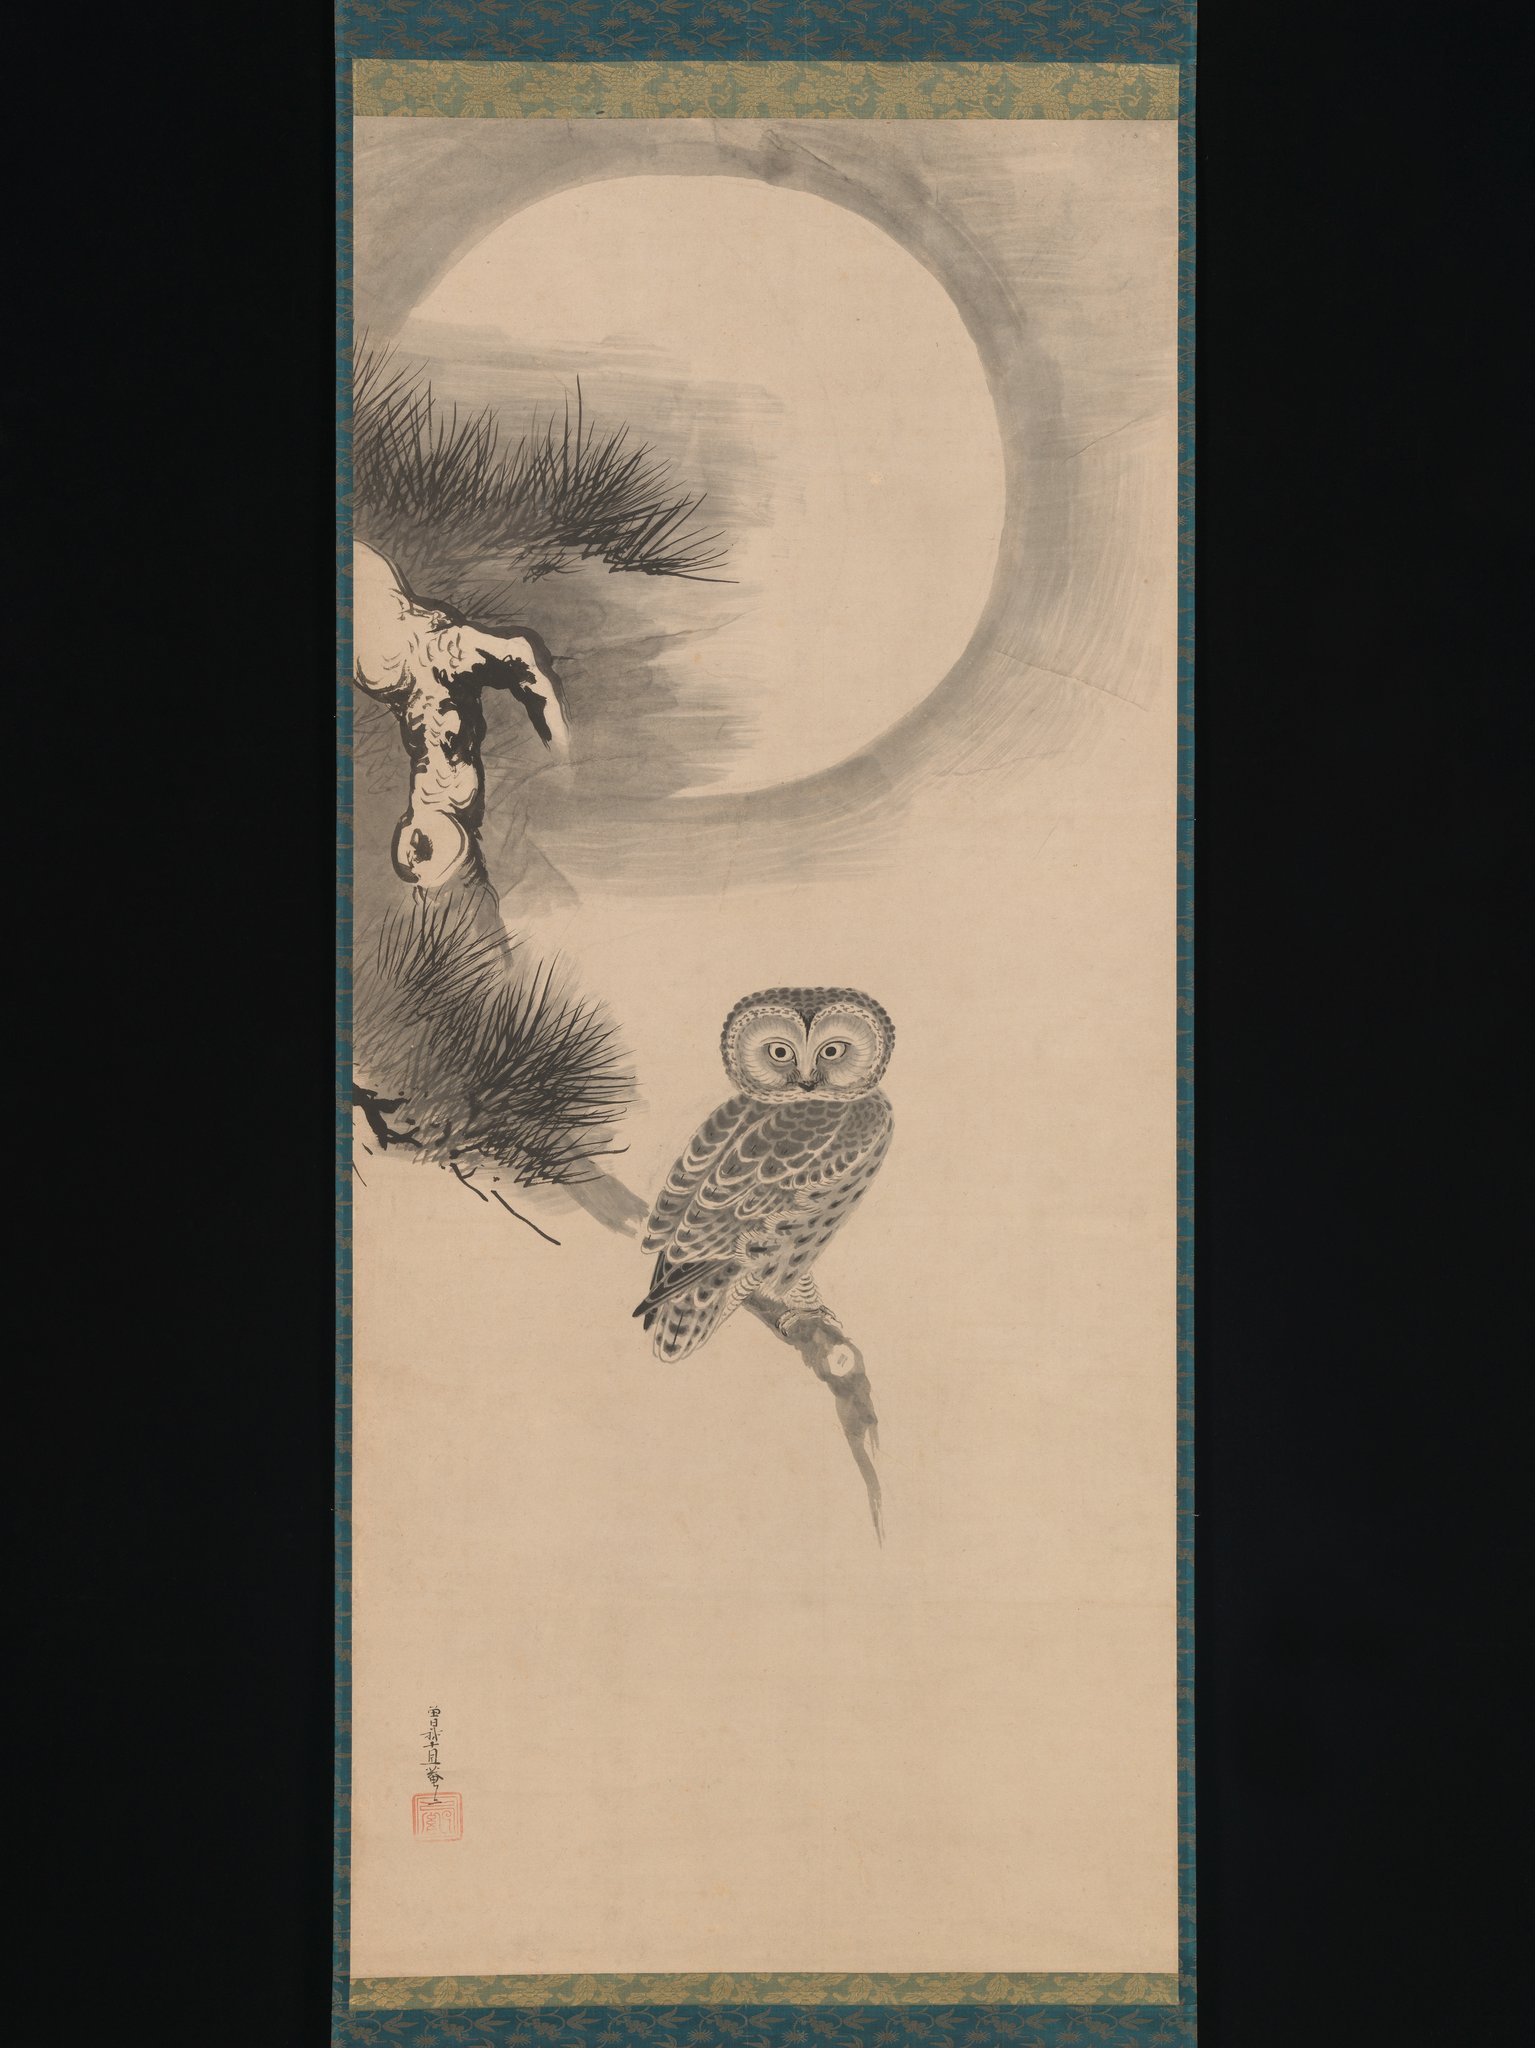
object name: hanging scroll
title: Owl on a Pine Branch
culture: japanese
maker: soga nichokuan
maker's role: artist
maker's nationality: japanese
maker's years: 1600-1700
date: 1601-1633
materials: ink, paper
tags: owls,moon